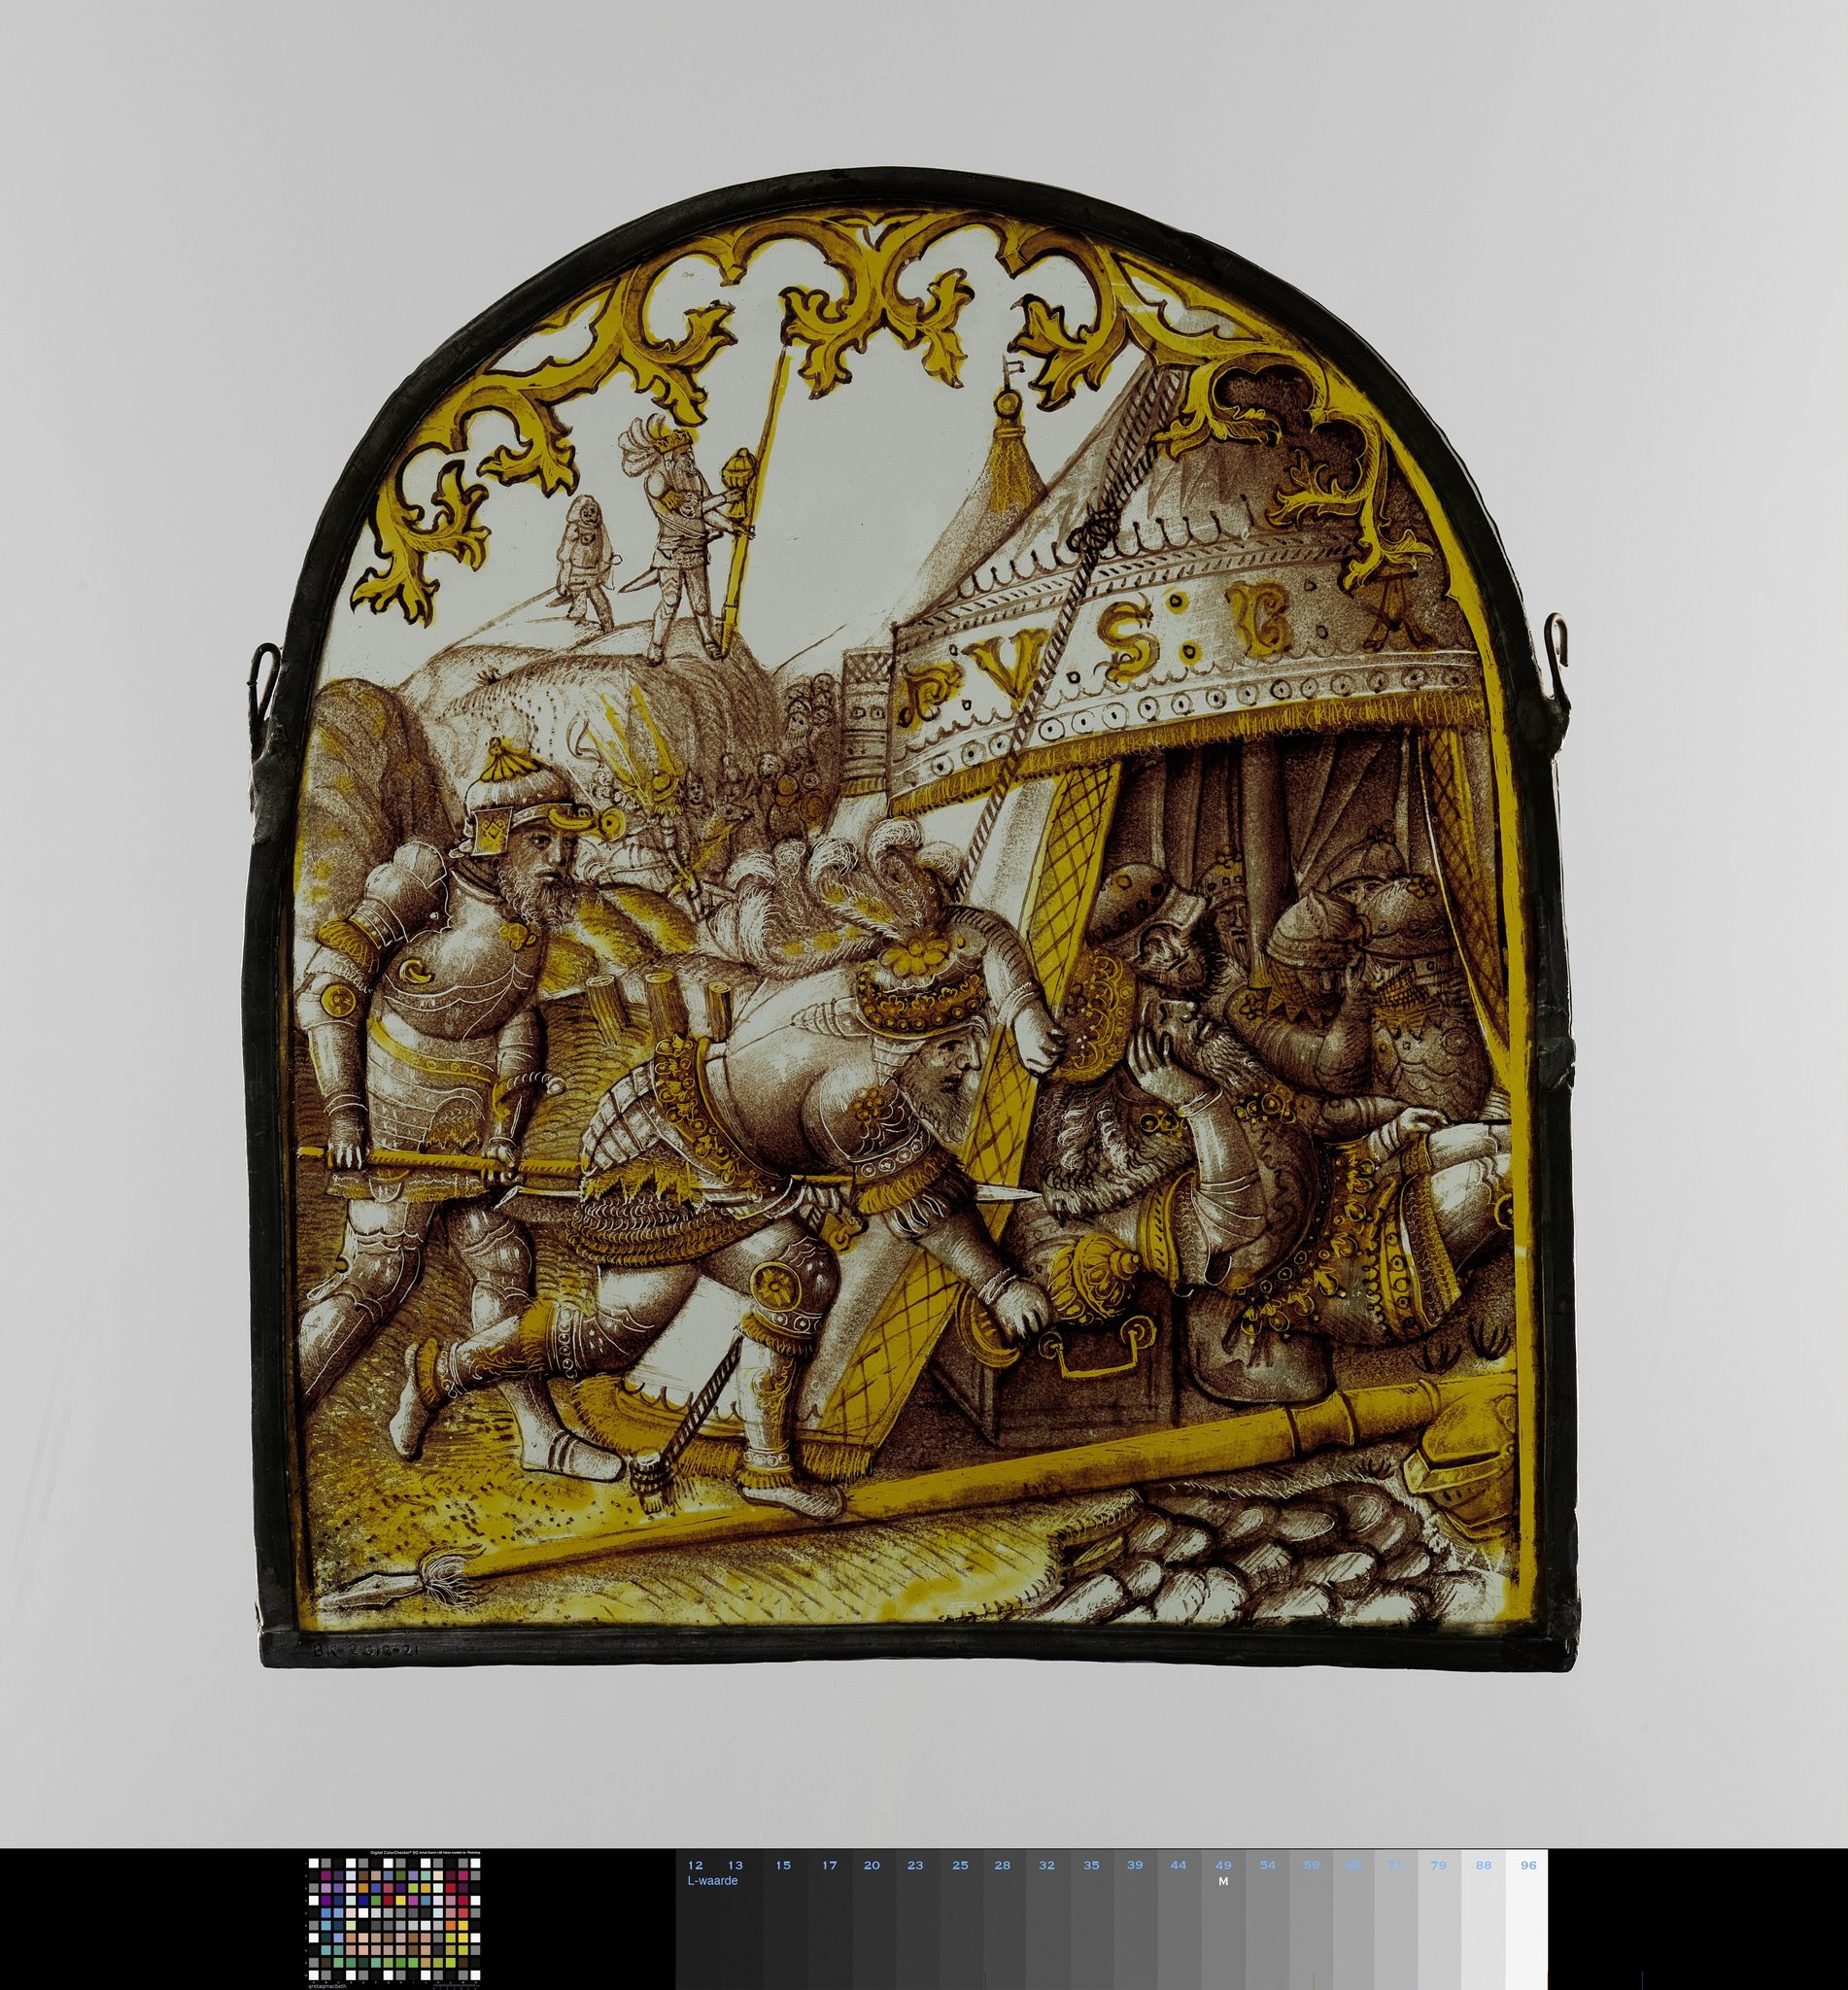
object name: light window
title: David en Abisaï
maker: Anonymous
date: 1520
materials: glass, lead, pigment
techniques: enamel painting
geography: low countries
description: David en Abisaï (1 Samuel 26:7). Ruit van gebrandschilderd glas in grisaille en zilvergeel, boogvormig. De scene wordt aan de gebogen bovenzijde afgesloten door een rand van Gotisch acanthuswerk, voortspruitend uit de rand van de voorstelling. De ruit behoort tot een reeks gewijd aan oudtestamentische scenes uit het leven van David.